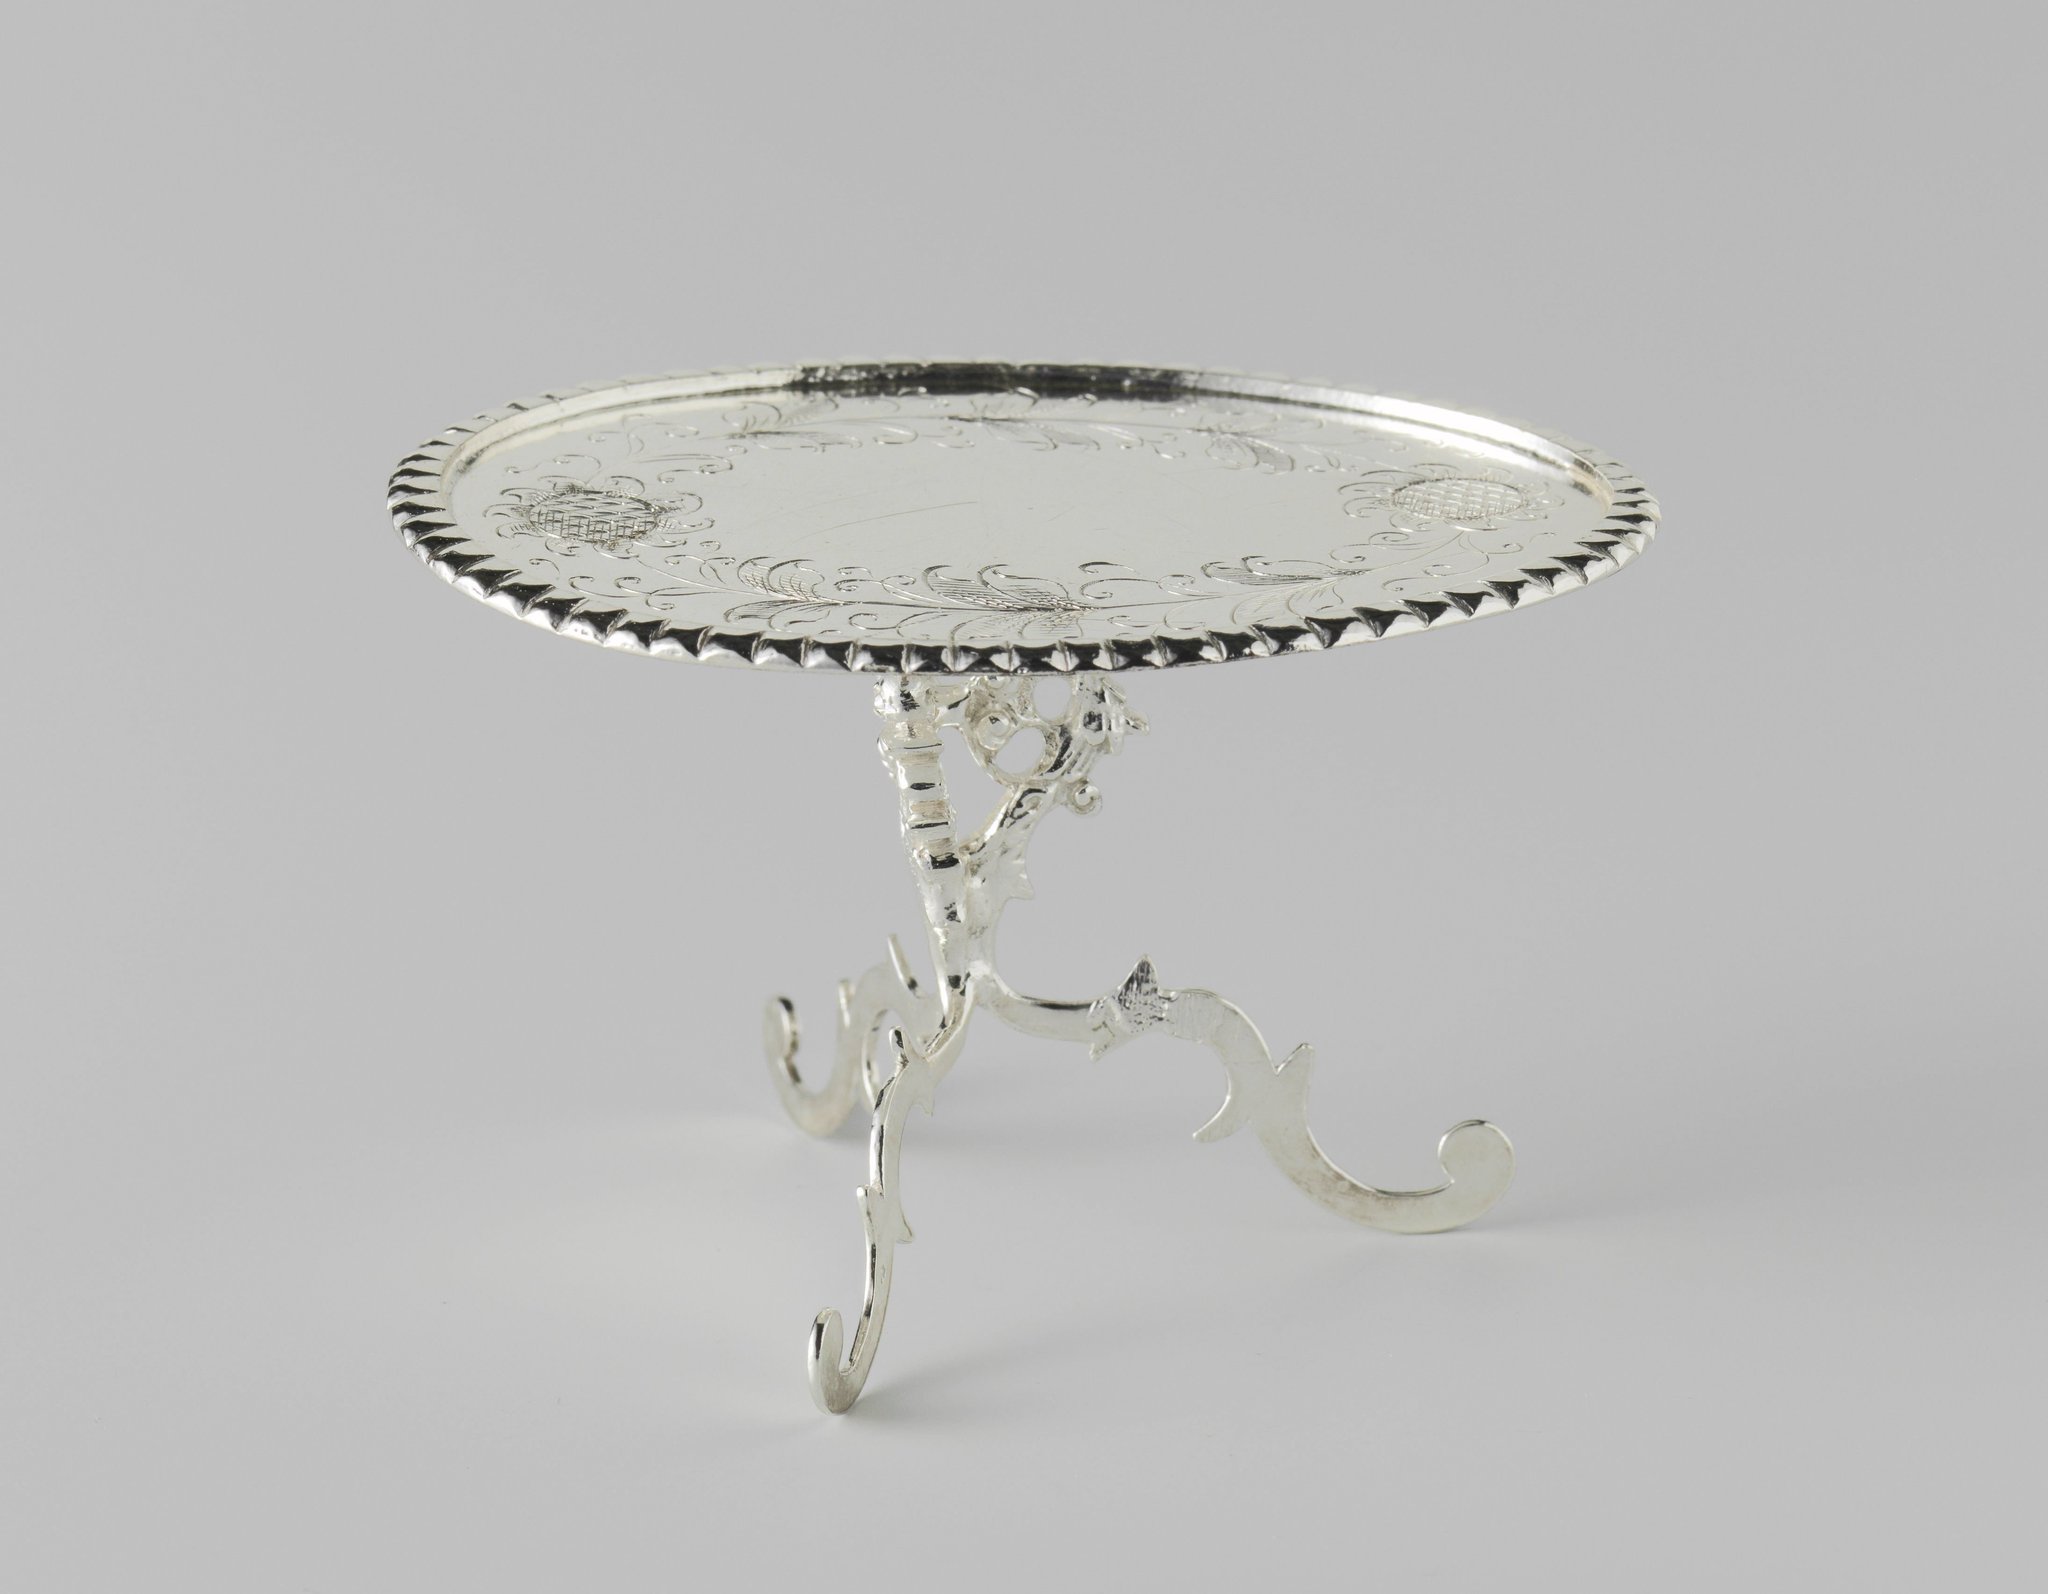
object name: miniature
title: Klaptafel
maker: frederik van strant (i)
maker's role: silversmith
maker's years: 1678-1727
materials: silver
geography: amsterdam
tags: tripod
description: Klaptafel op een driepoot. Het ovale blad heeft een bewerkte rand en een gegraveerde versiering van zonnebloemen en ranken. Het blad rust op drie gegoten kariatiden, die overgaan in de driepoot. De tafel is gemerkt: stk.= Amsterdam, mt.= Frederik van Strant I en een bijltje.